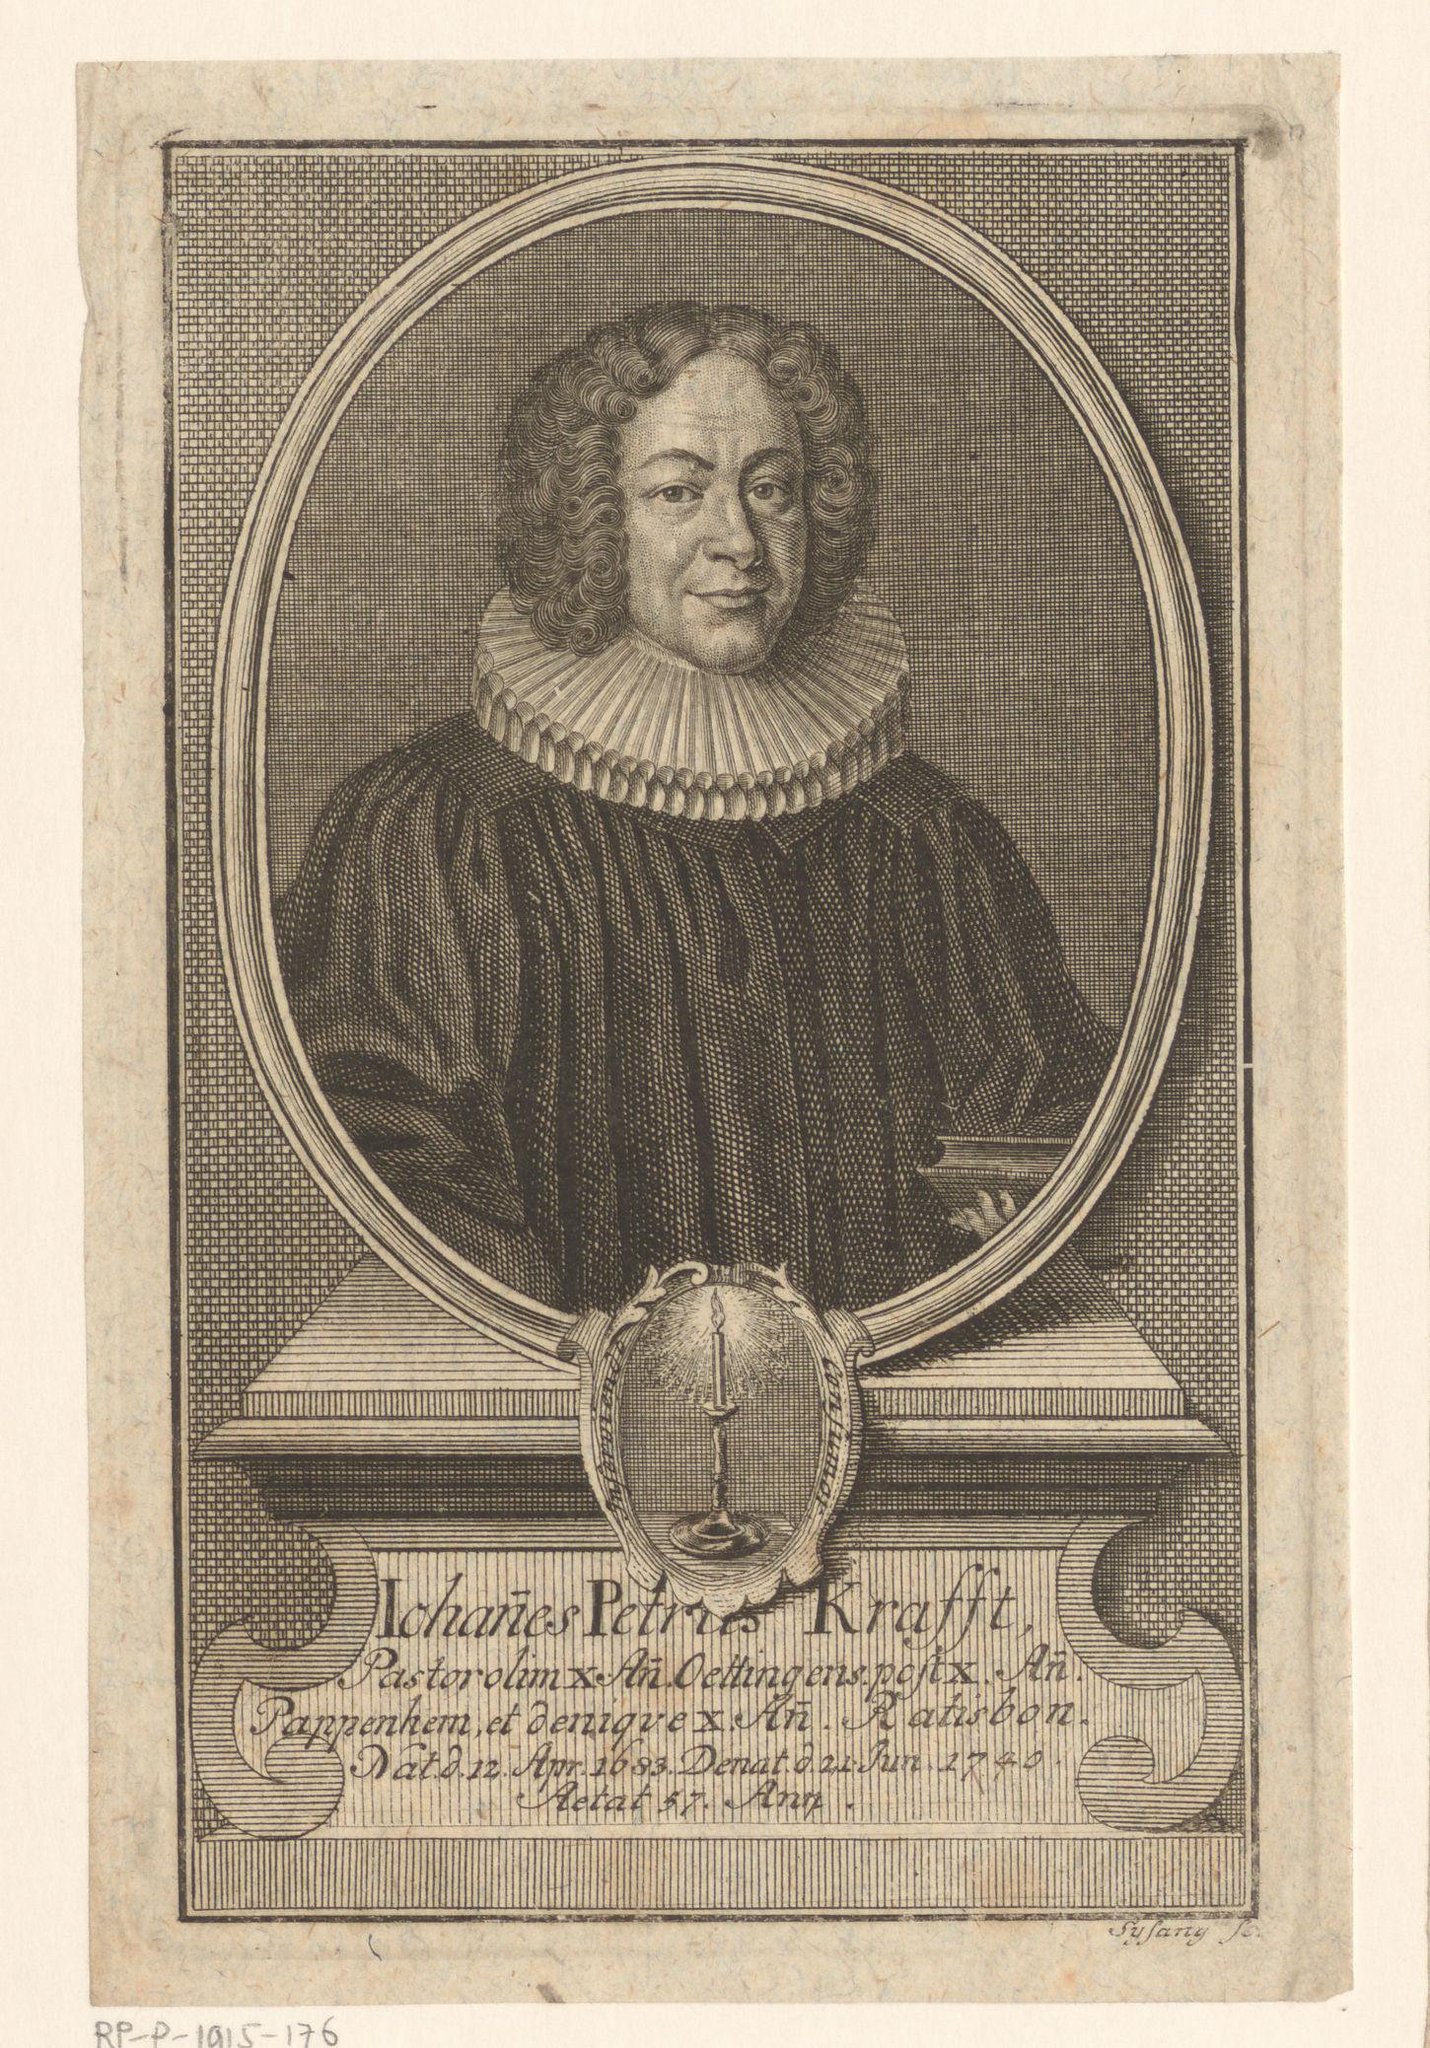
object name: print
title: Portret van Johann Peter Krafft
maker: johann christoph sysang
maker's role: print maker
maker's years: 1703-1757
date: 1740-1757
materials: paper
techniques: engraving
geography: leipzig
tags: historical persons, candle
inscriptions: collector's mark: Lugt 2233